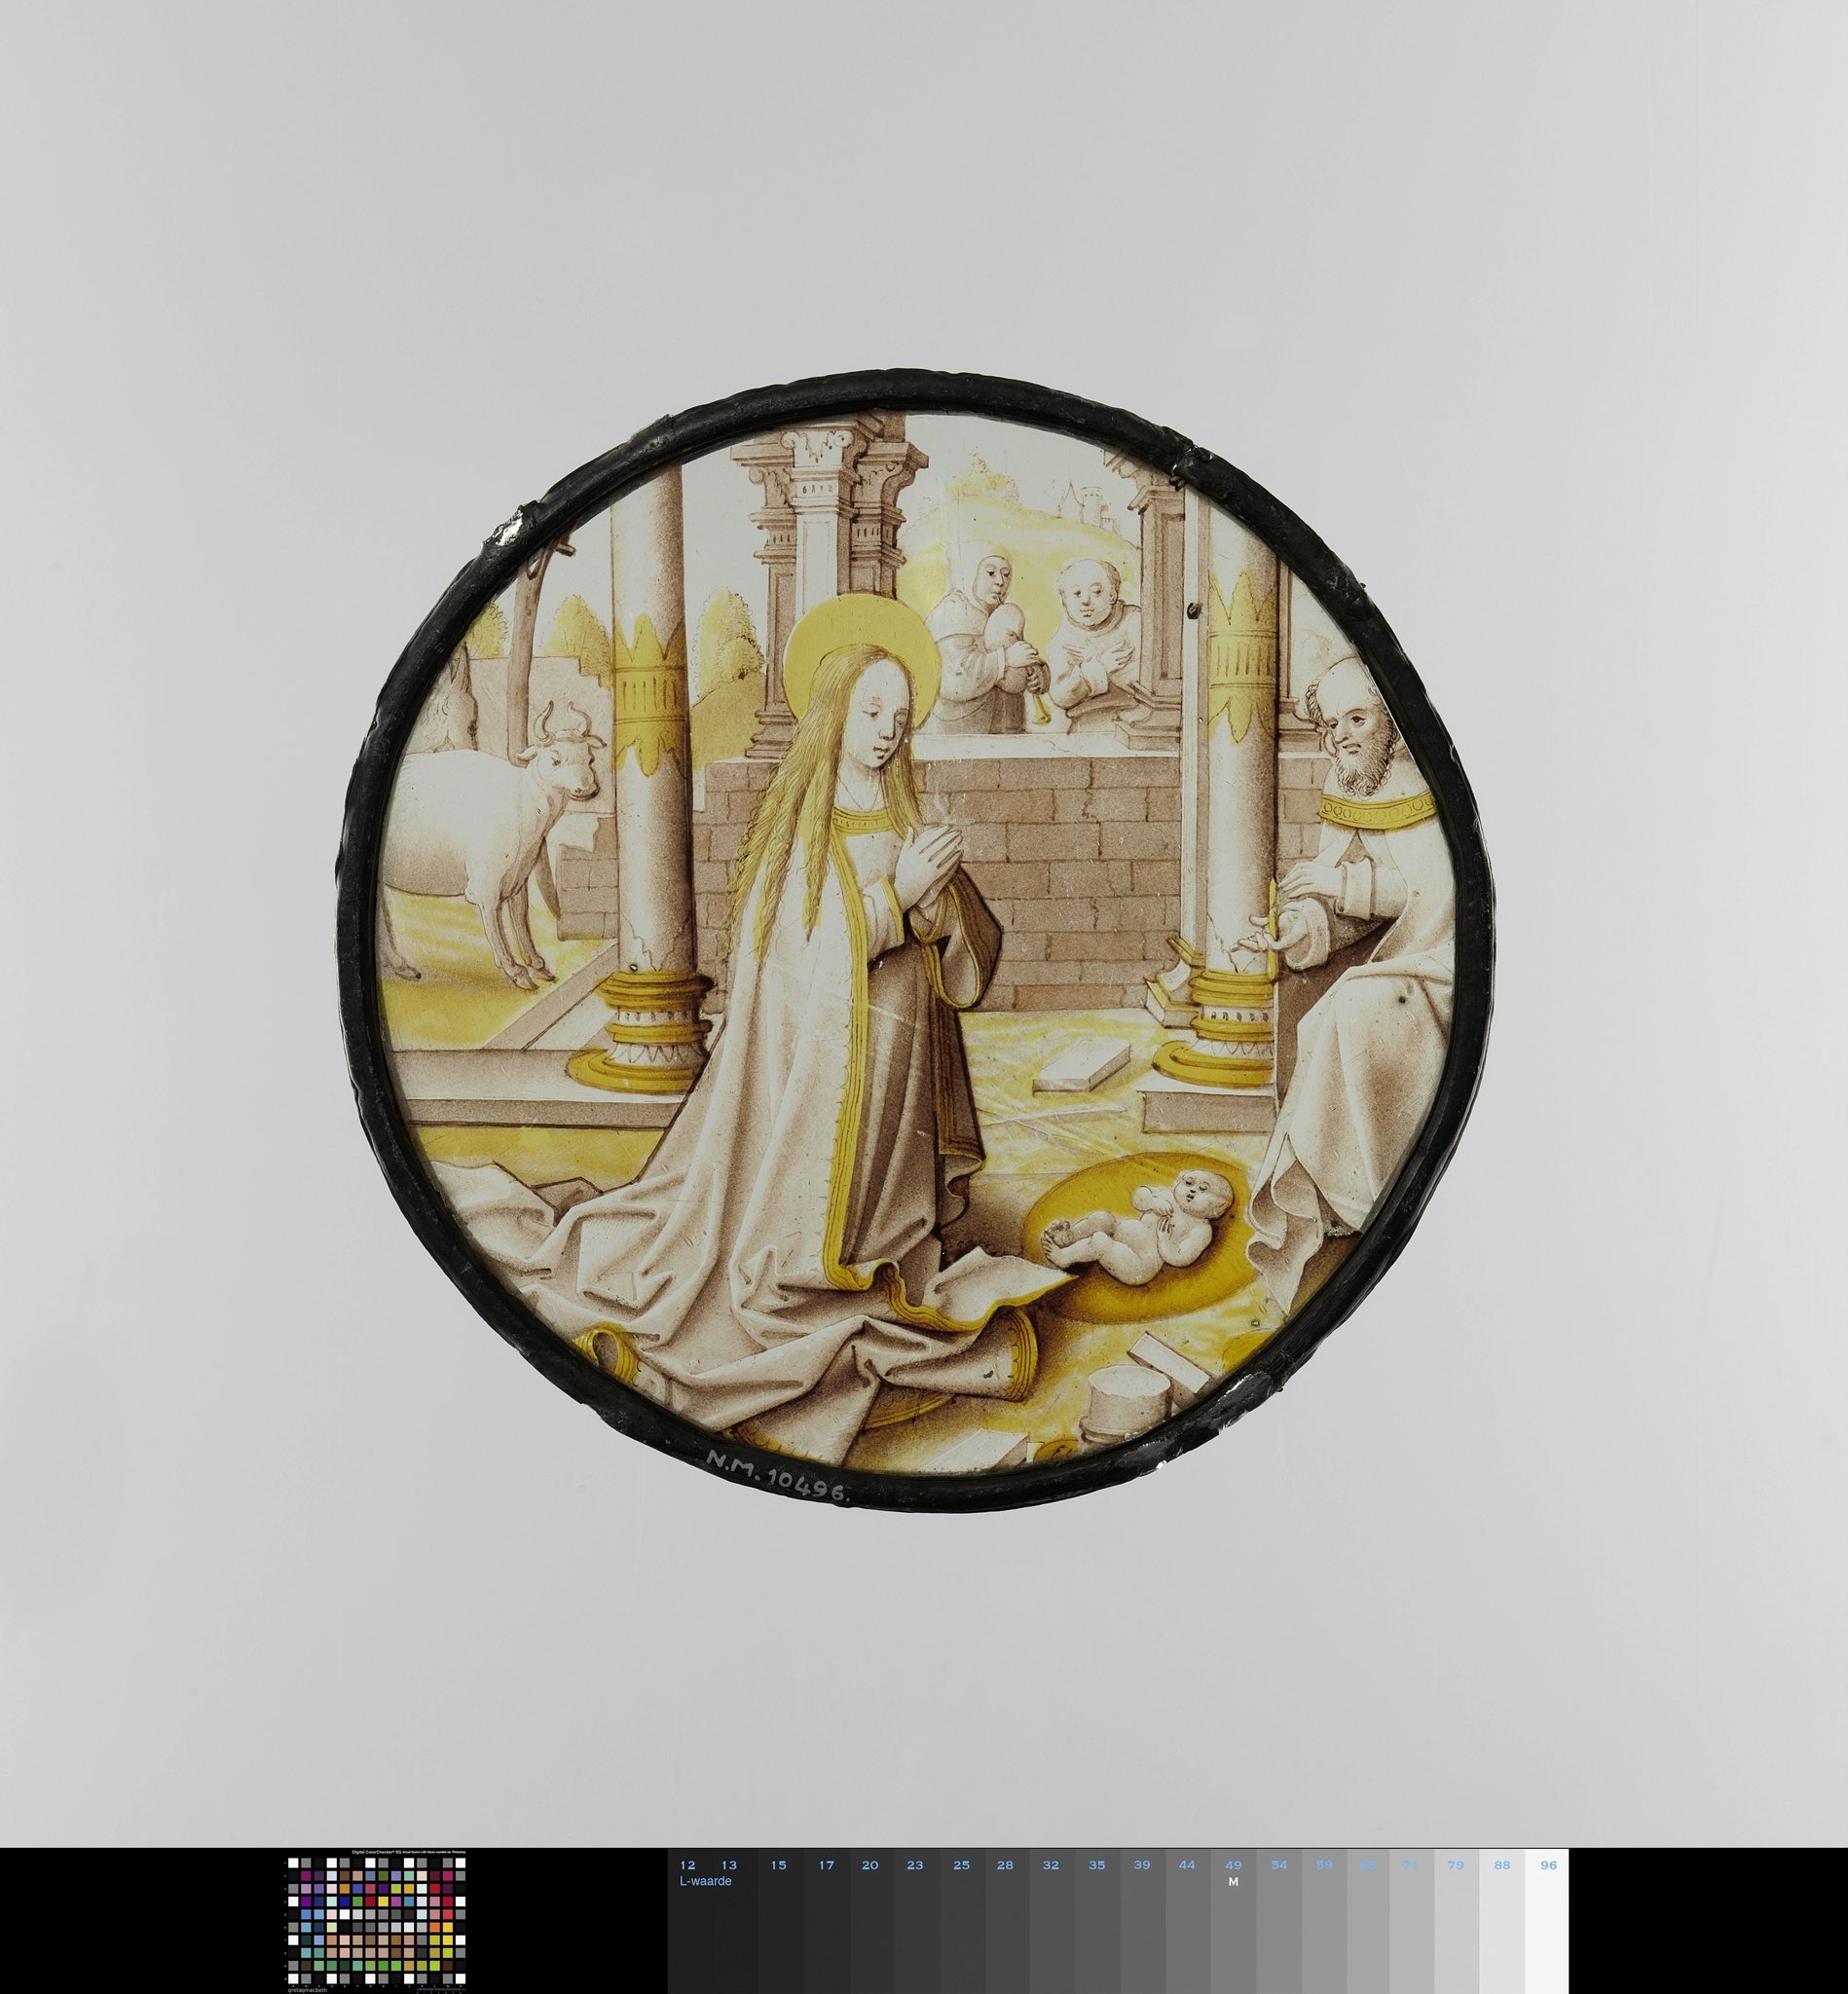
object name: light window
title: Ruit met de Geboorte van Christus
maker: Anonymous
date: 1515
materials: glass, lead, pigment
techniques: leading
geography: southern netherlands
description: Een ronde gebrandschilderde ruit met de voorstelling van de geboorte van Christus.